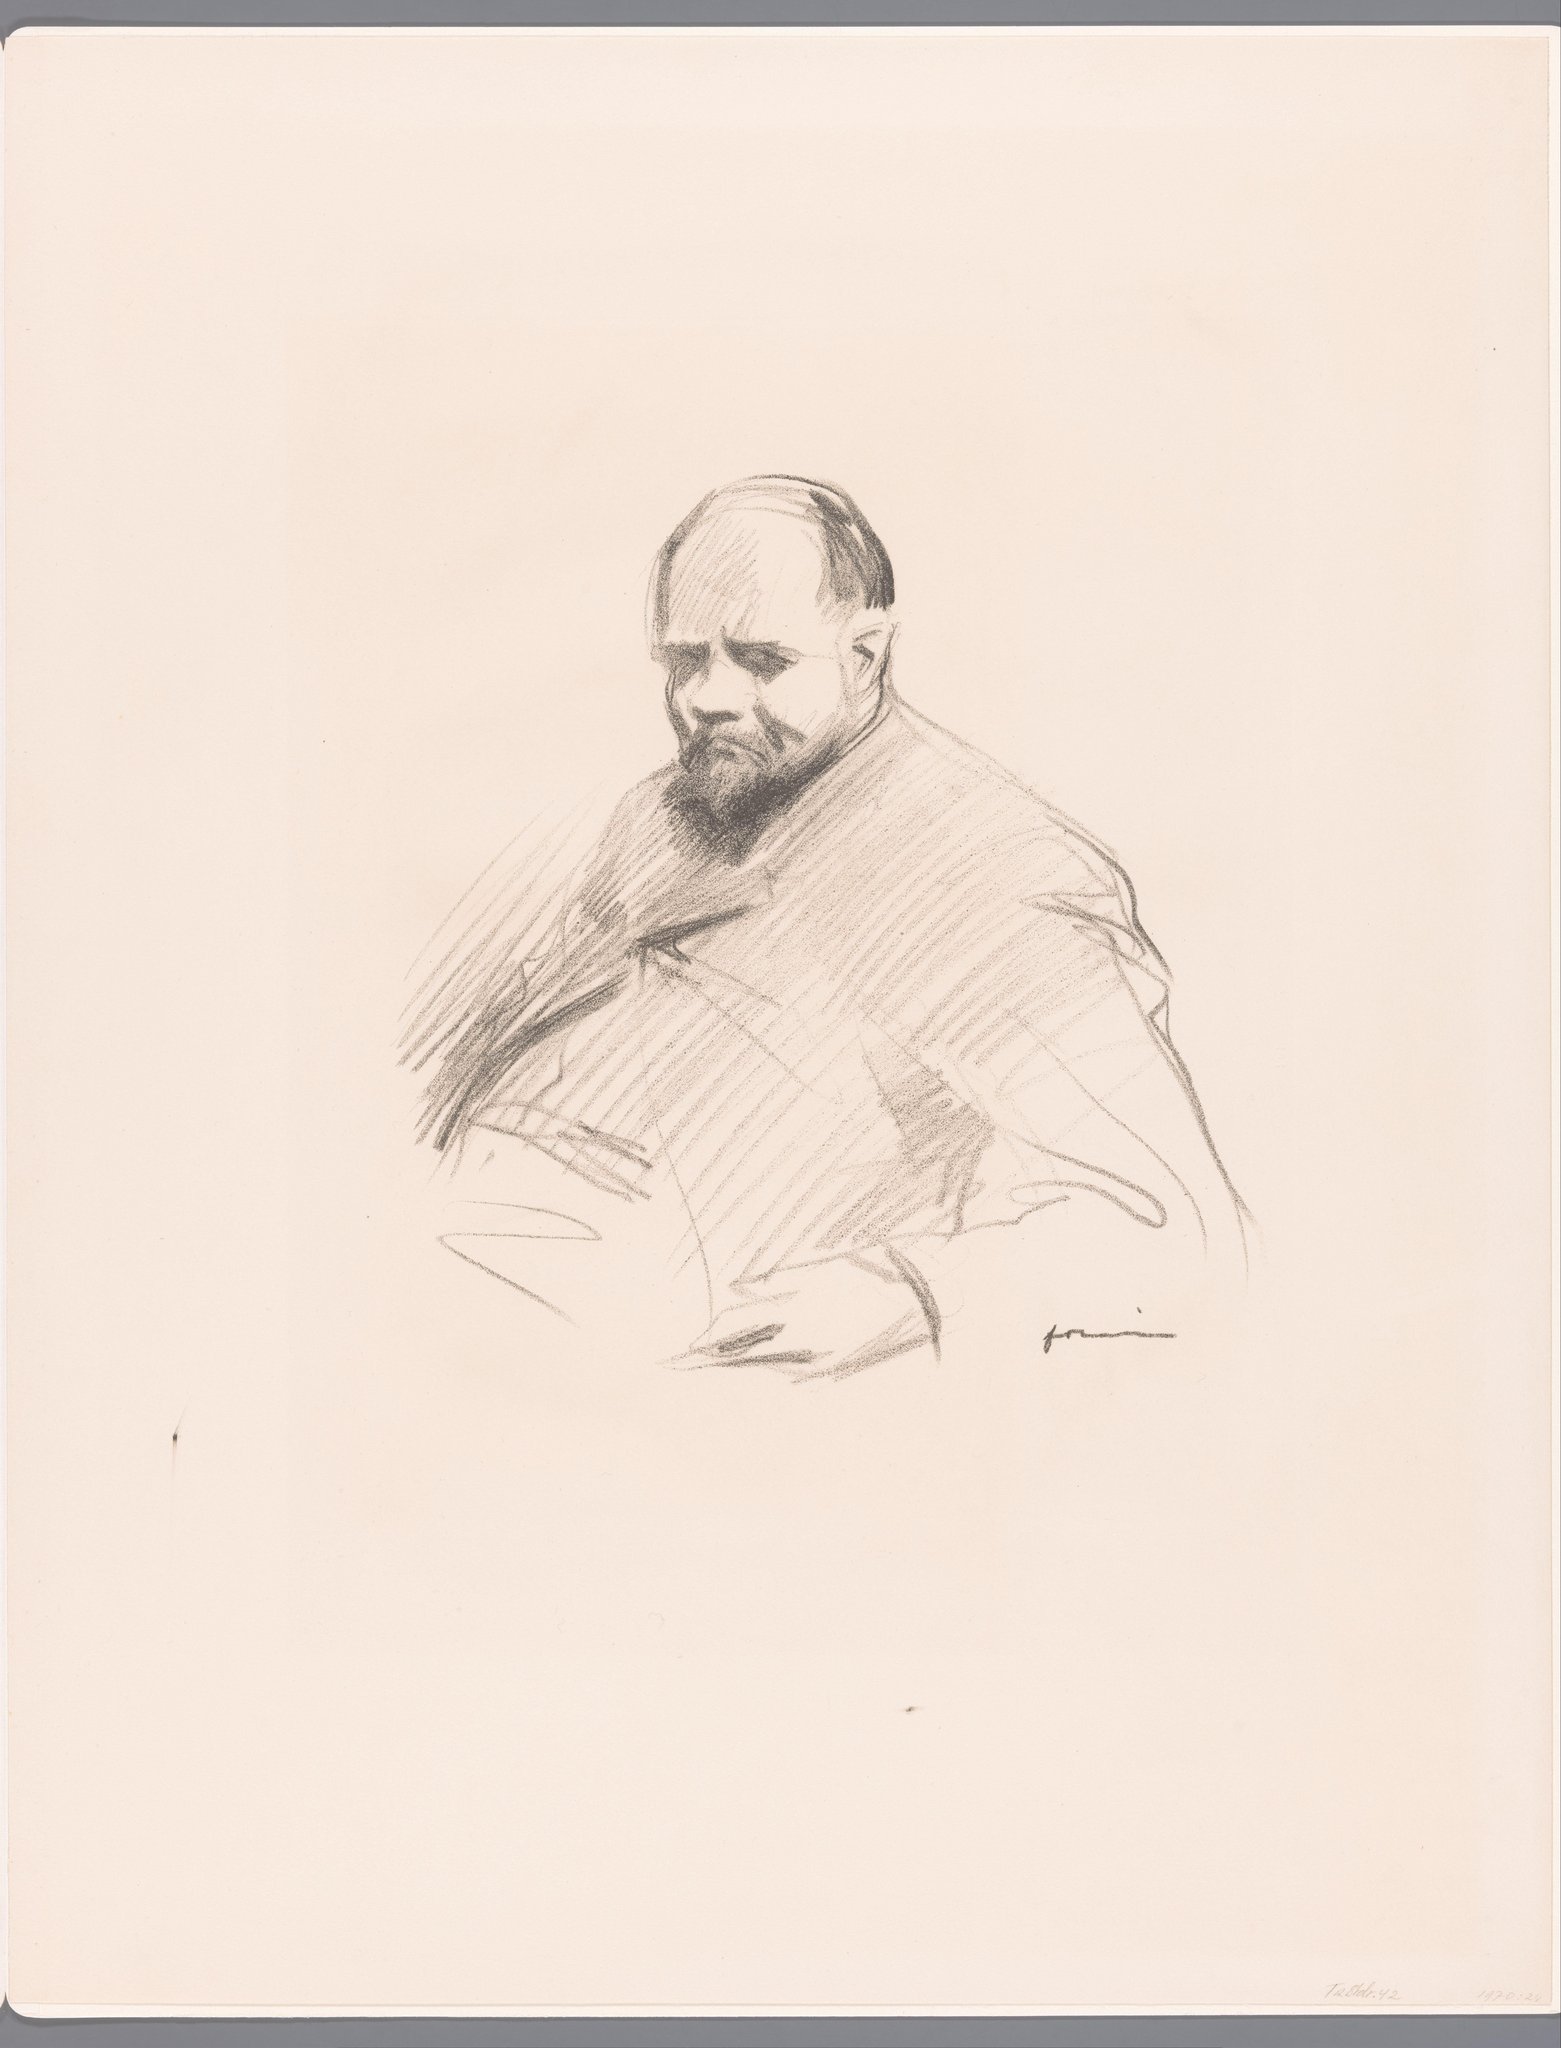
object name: print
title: Portret van Ambroise Vollard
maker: jean-louis forain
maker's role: painter, print maker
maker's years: 1852-1931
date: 1910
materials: paper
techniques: lithography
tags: publisher, henri louis ambroise vollard, historical persons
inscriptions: collector's mark: Lugt 2228a, collector's mark: Lugt 2760